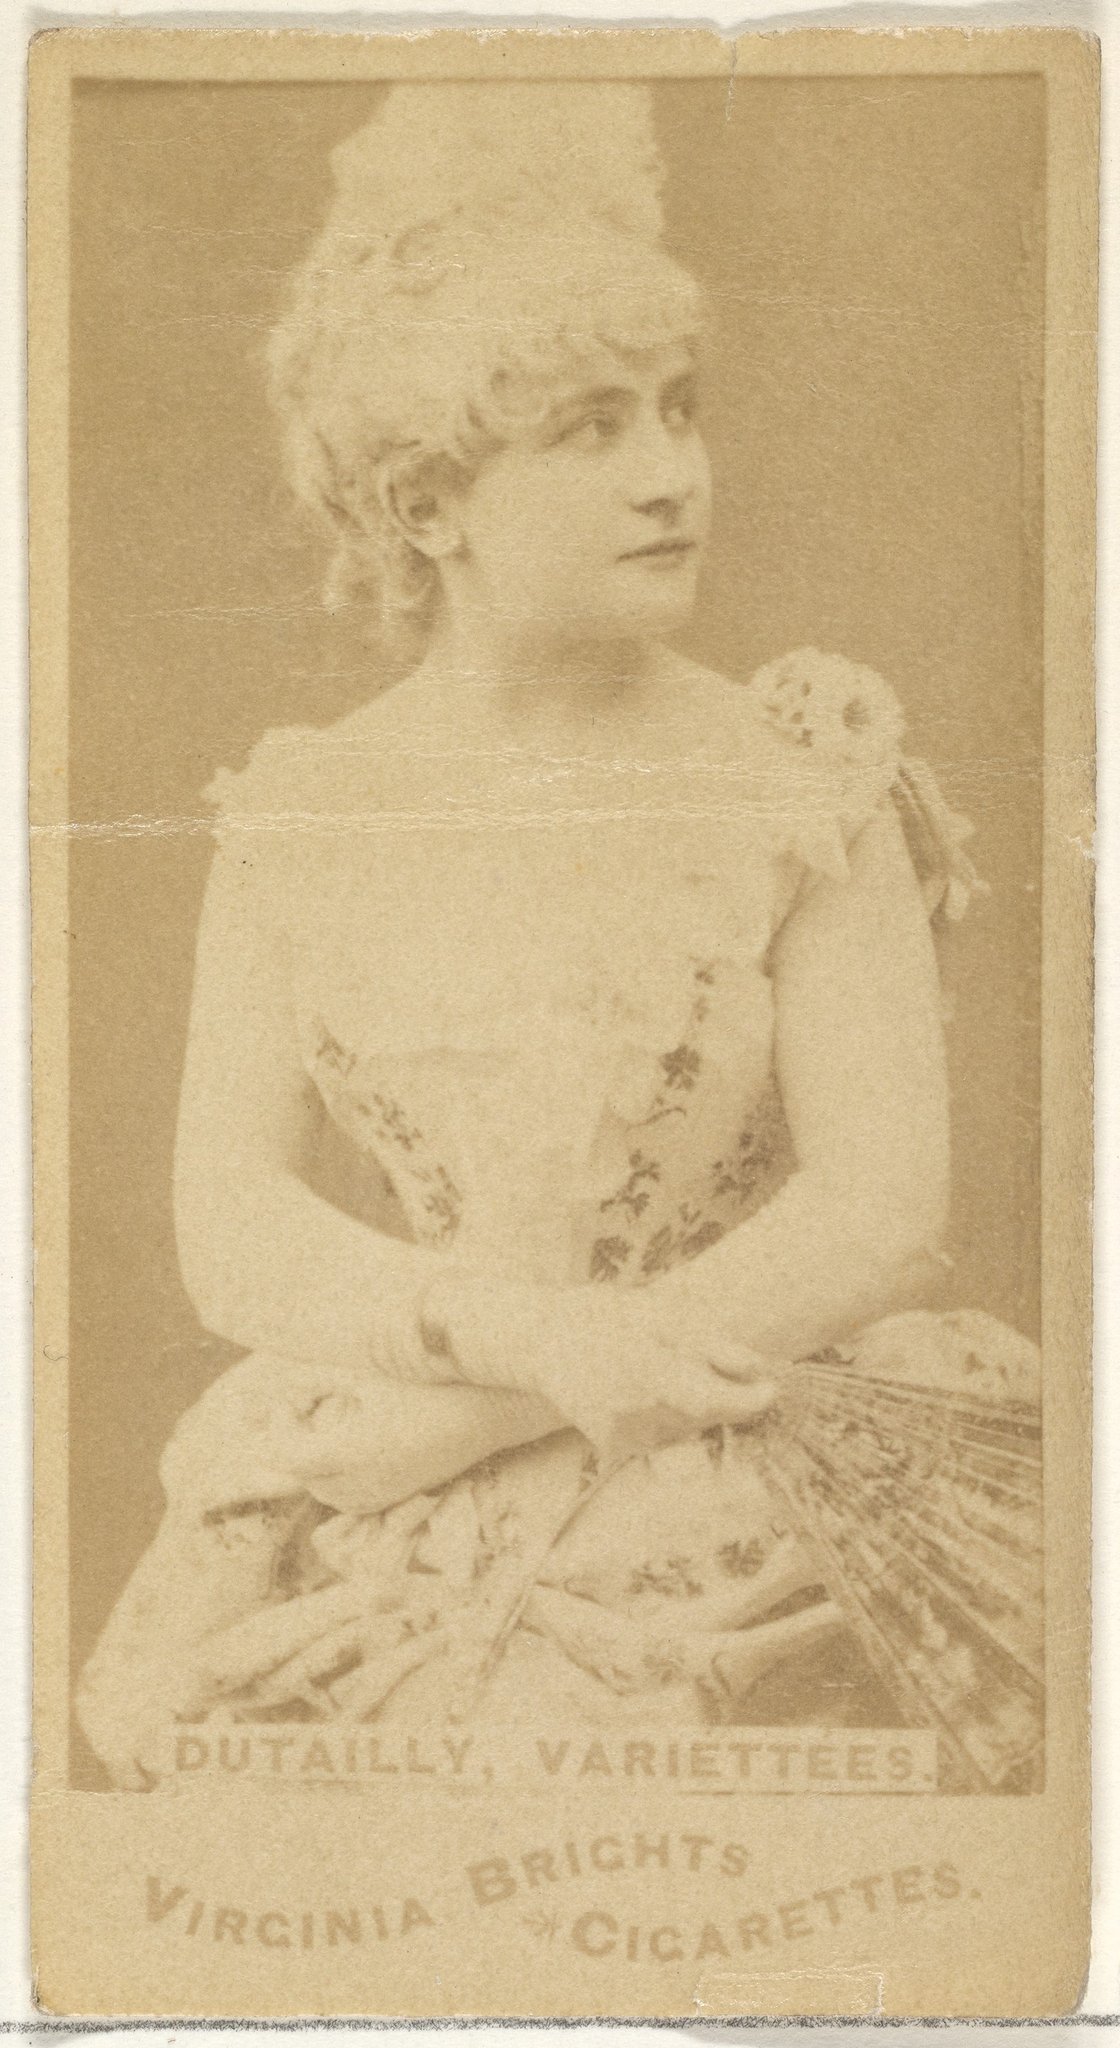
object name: photograph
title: Dutailly, Variettees, from the Actors and Actresses series (N45, Type 1) for Virginia Brights Cigarettes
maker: allen & ginter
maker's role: publisher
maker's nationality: american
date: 1888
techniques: albumen silver print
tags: portraits,women,actresses